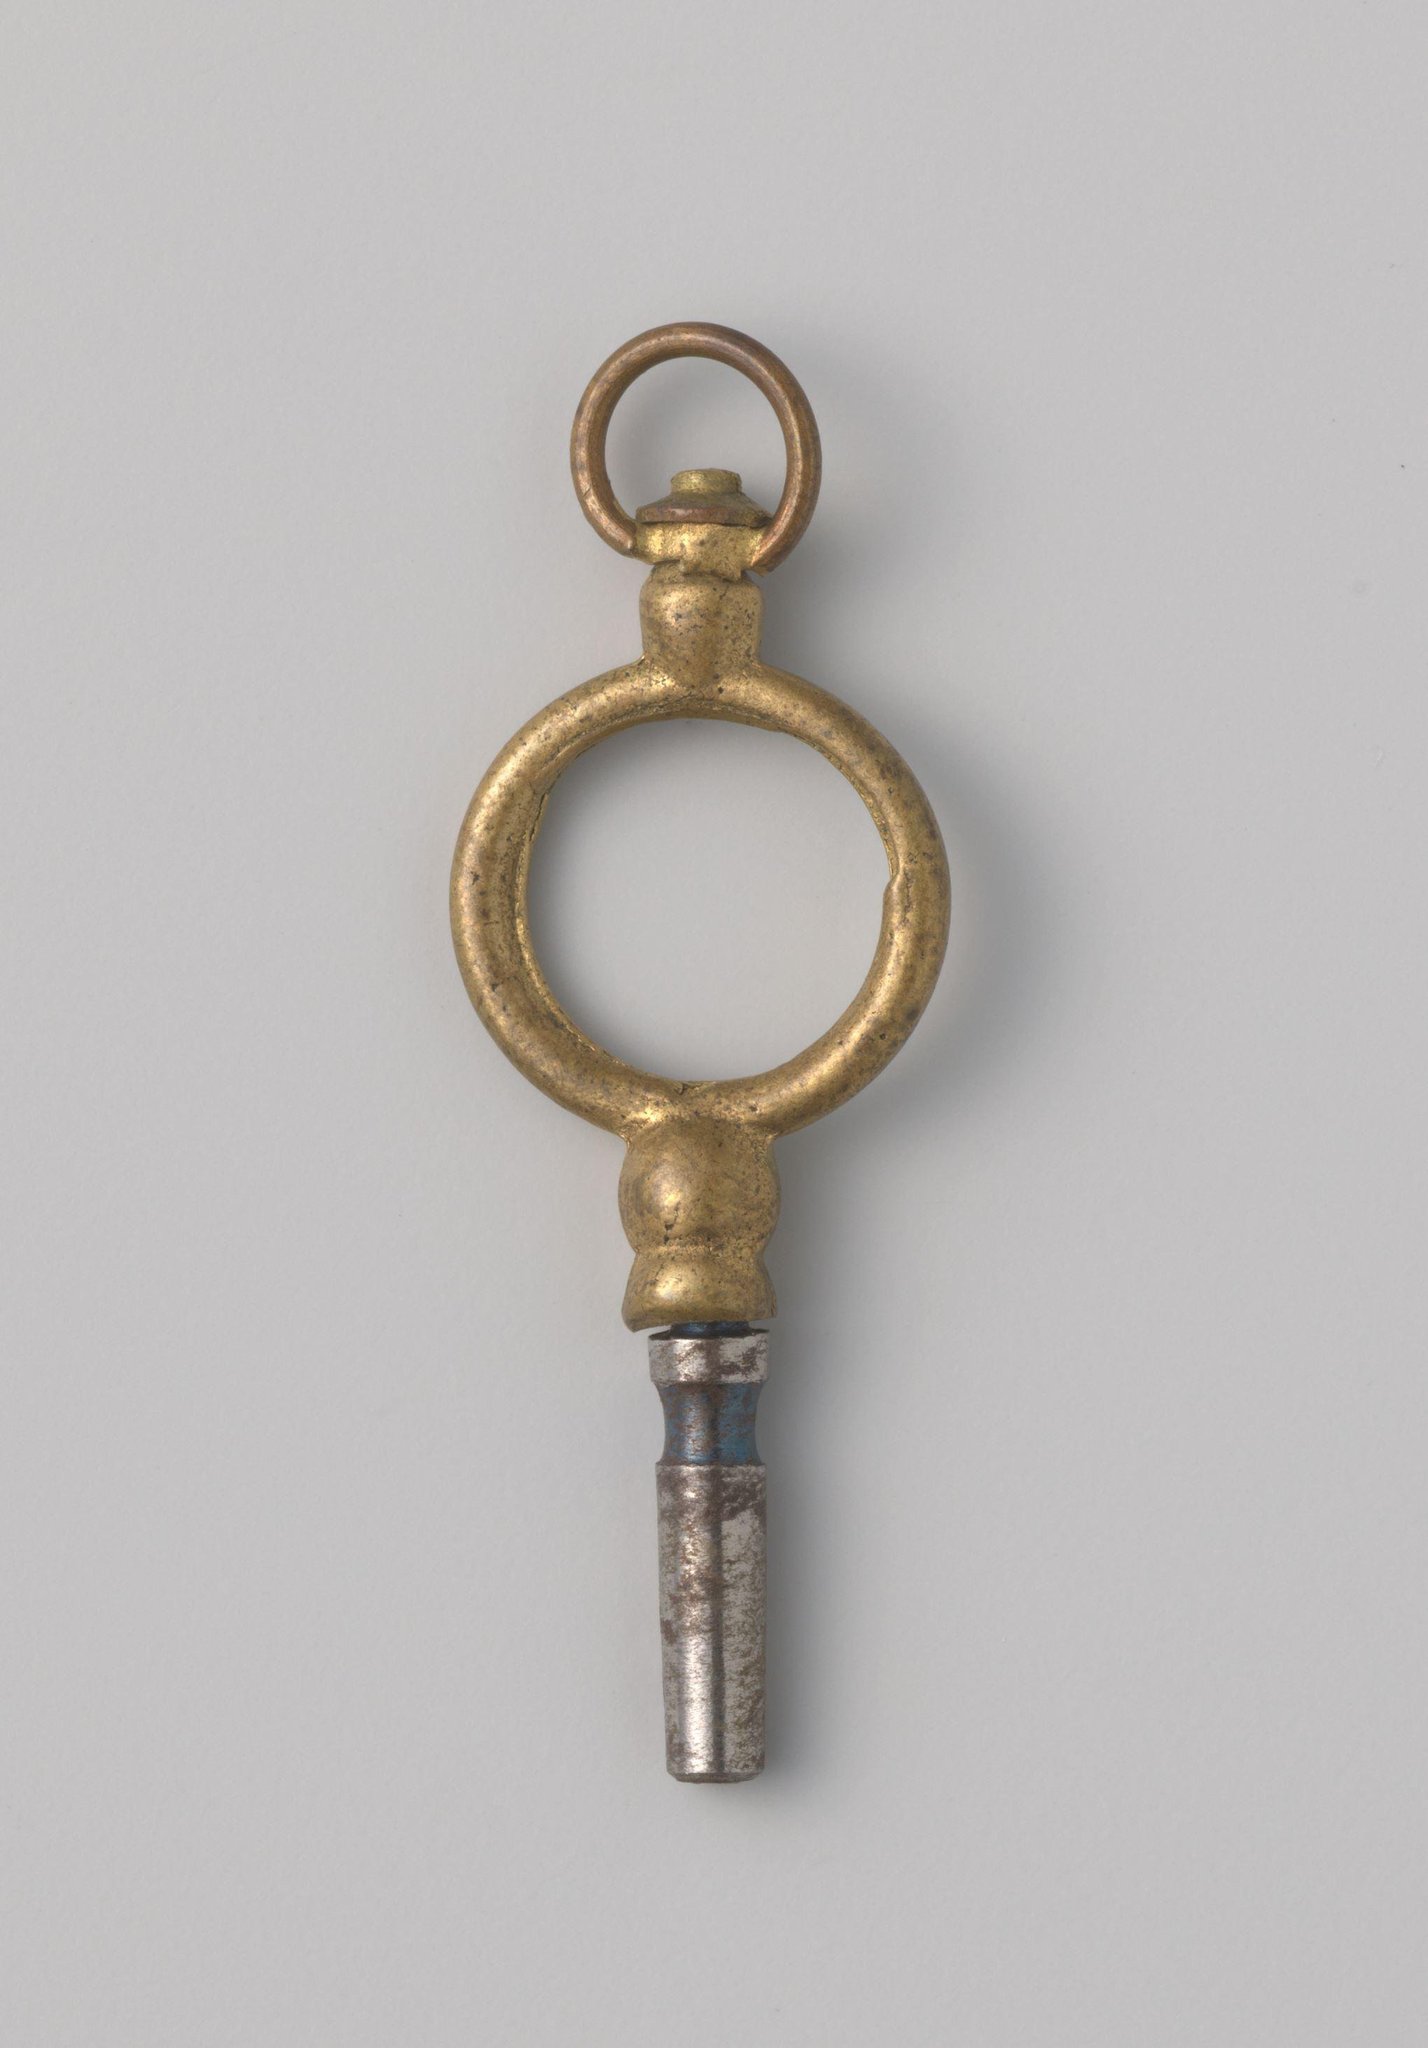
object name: key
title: Sleutel behorend bij een repetitiehorloge met een muziektrofee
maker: Anonymous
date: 1775-1800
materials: gold, silver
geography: france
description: Sleutel behorend bij een repetitiehorloge met een muziektrofee.